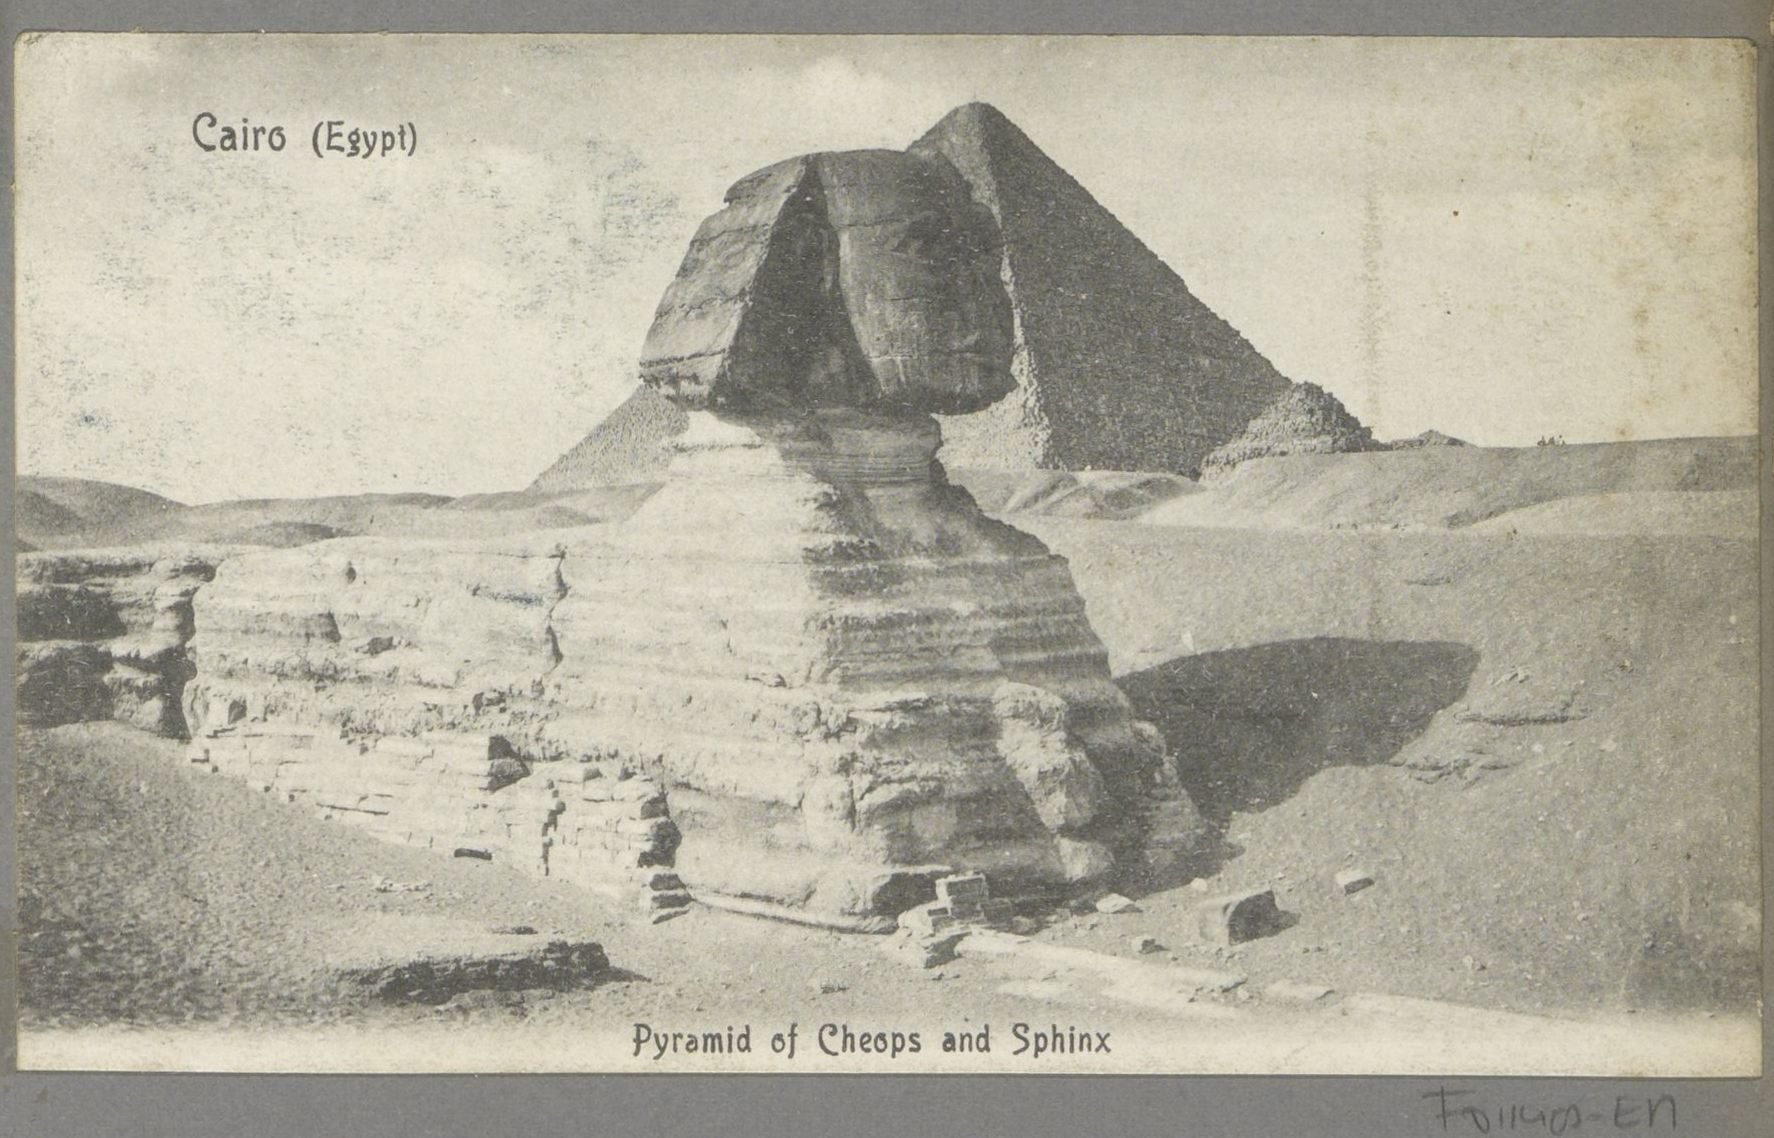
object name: ansichtkaart, prentbriefkaart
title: Cairo (Egypt) Pyramid of Cheops ans Sphinx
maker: Anonymous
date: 1895-1905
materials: paper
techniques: photograph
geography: cairo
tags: sphinx (lion/woman); 'sfinge' (ripa) - aa - female human figure, pyramid (historical grave form)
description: Onderdeel van Reisalbum met foto's van bezienswaardigheden in Griekenland en Egypte.